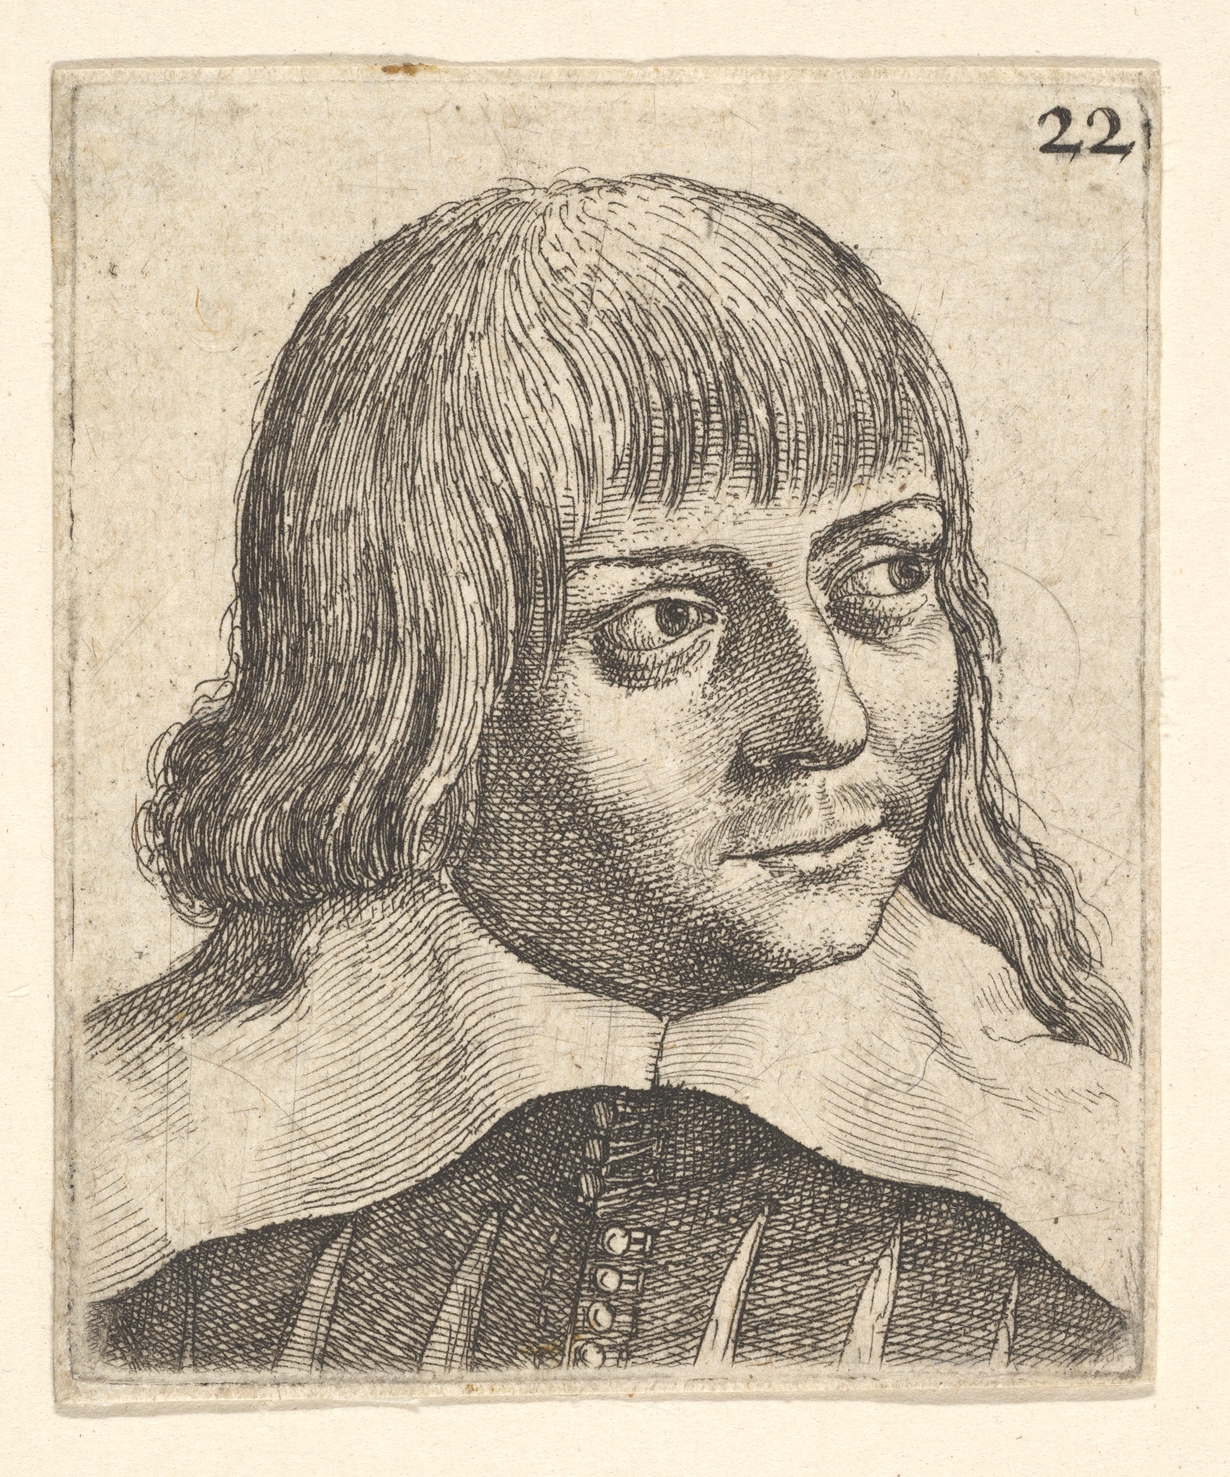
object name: print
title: Head of a young man, turned slightly to right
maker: wenceslaus hollar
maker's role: artist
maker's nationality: bohemian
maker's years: 1607-1677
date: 1635-1636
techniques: etching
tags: heads,men,portraits